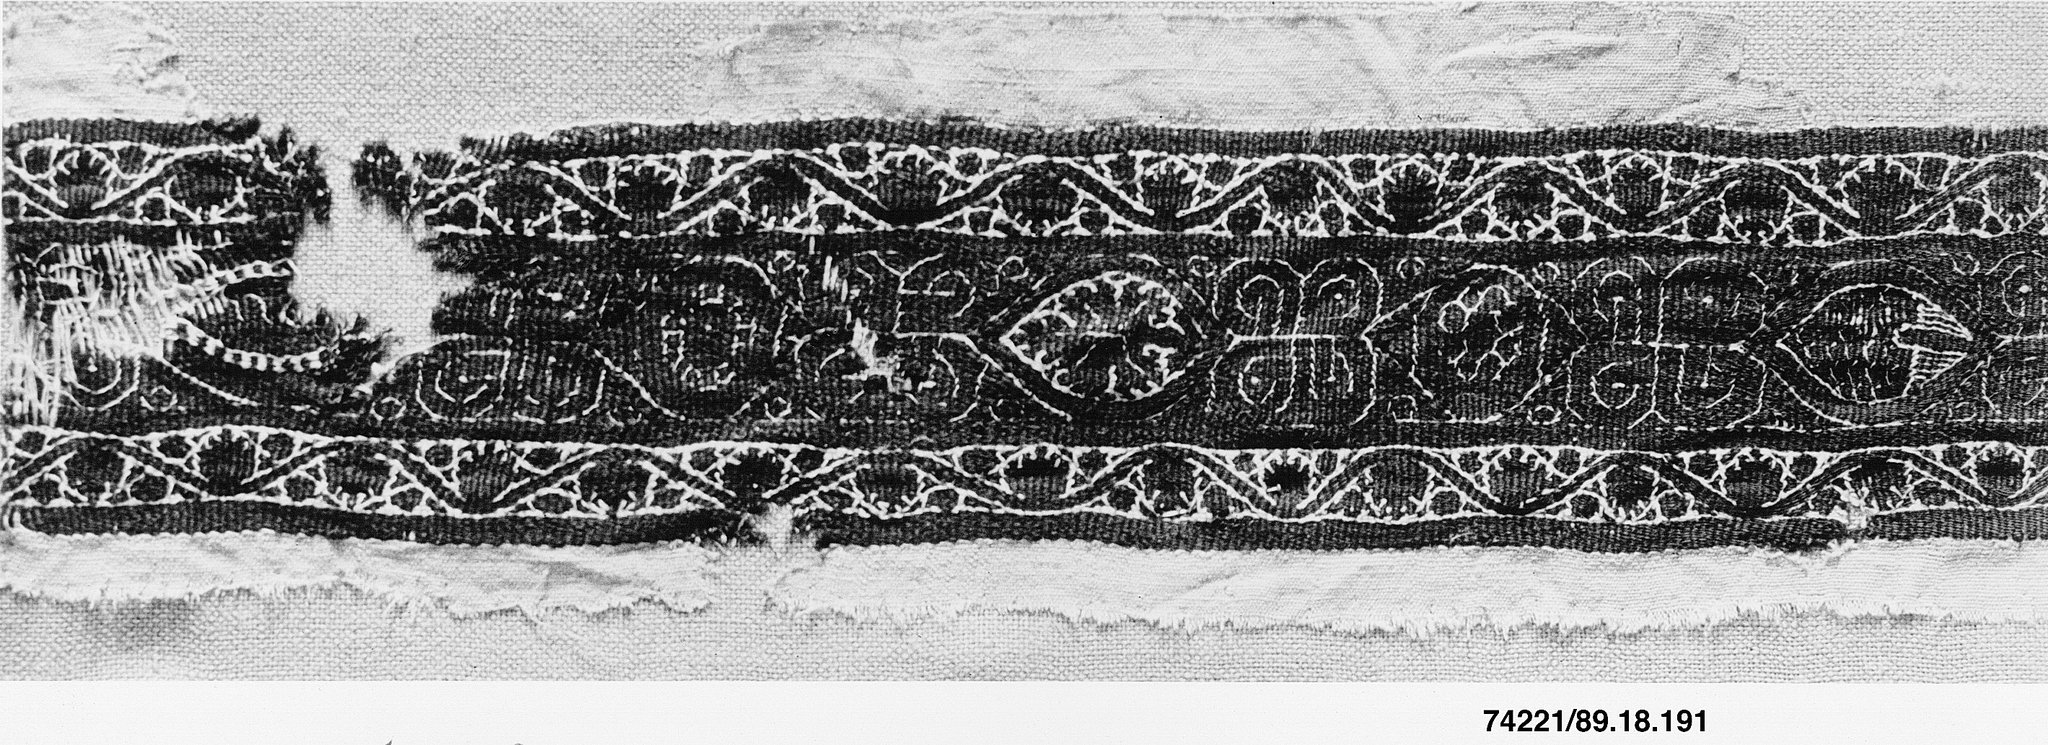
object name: textile fragment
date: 201-400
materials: linen, wool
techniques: weave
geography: egypt